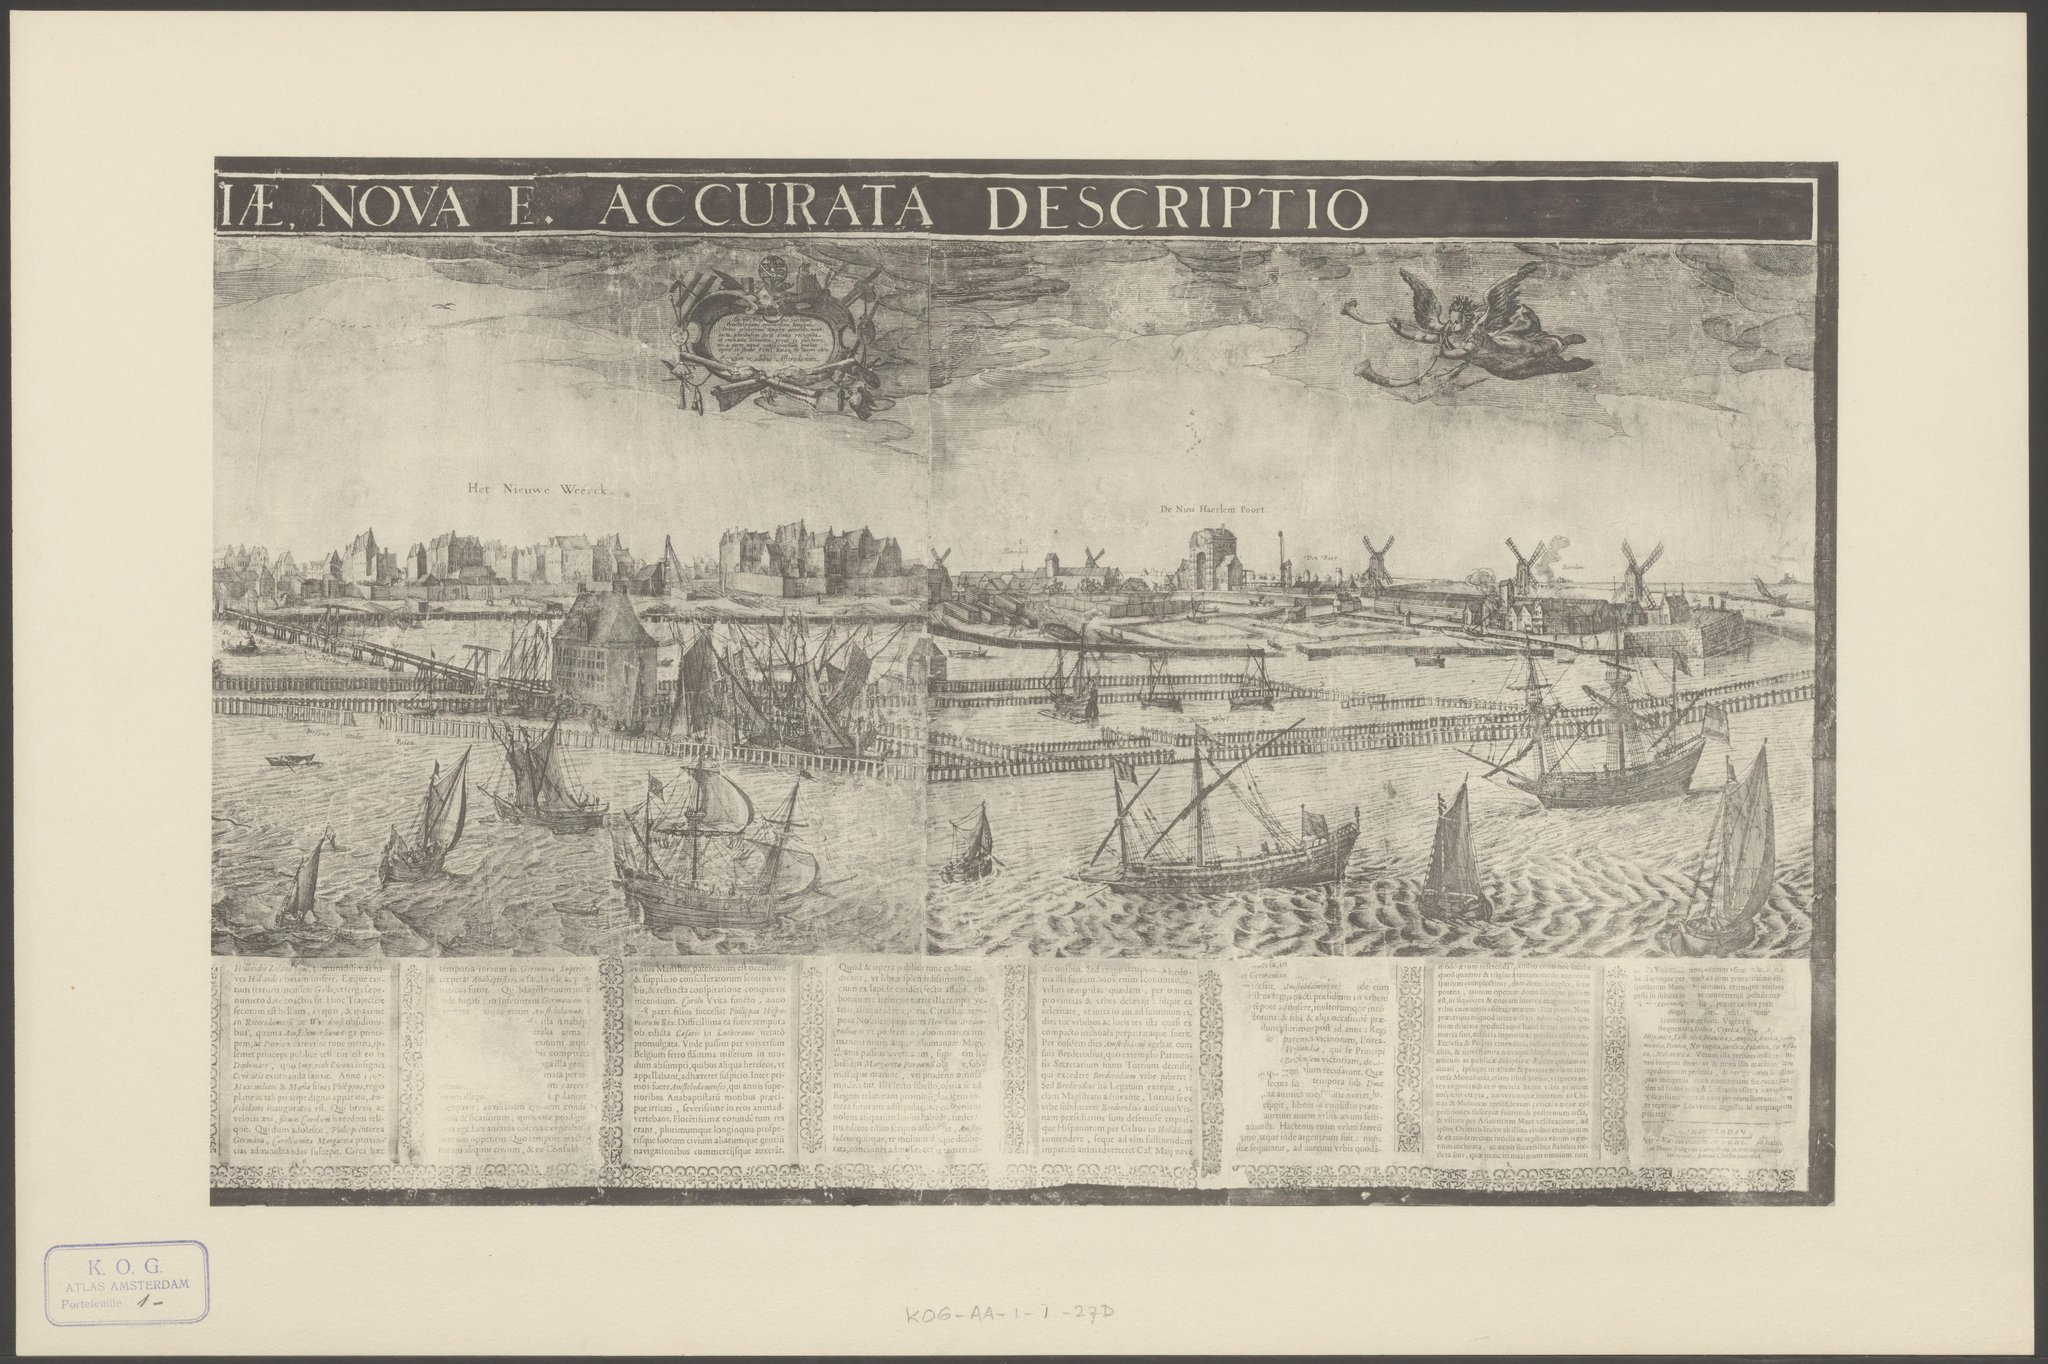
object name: photomechanical print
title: Gezicht op de stad Amsterdam vanaf het IJ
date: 1913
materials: paper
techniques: photograph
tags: city-view in general; 'veduta', river, ships (in general) - cc - more than one ship, amsterdam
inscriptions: collector's mark: ‘1’ Lugt 1641b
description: Onderwerpsrubriek binnen de Atlas Amsterdam: Gezichten van den geheelen IJkant der Stad.